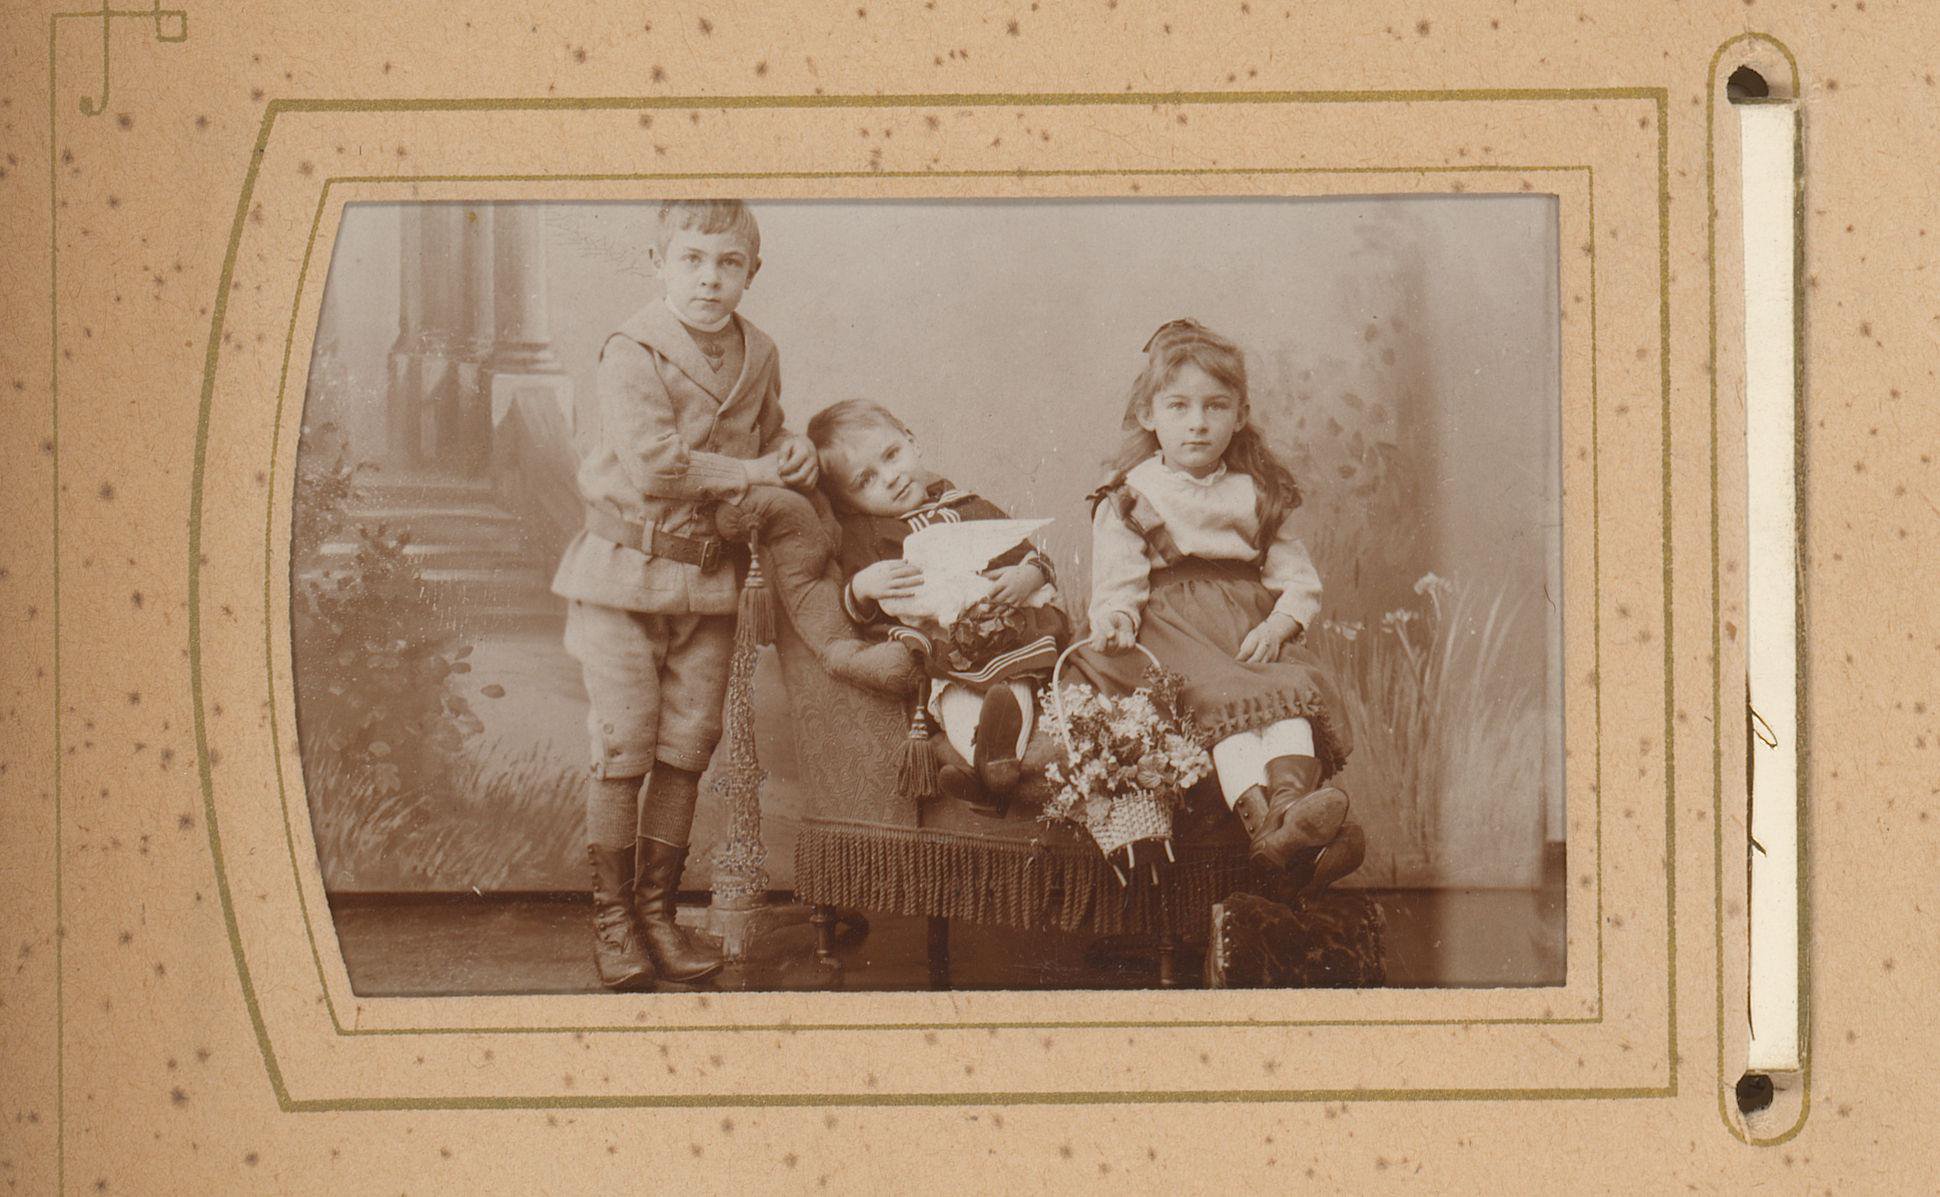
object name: album leaf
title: Portret van drie kinderen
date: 1880-1920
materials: cardboard, photographic support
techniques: collodion silver print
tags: boy (child between toddler and youth) (+ two persons), girl (child between toddler and youth), anonymous historical persons portrayed in a group, in a group-portrait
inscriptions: inscription: ‘Atelier Opitz/ BERLIN, N./ Veteranenstr. 28./ NOWAWES,/ Priesterstr. vor No. 1.’